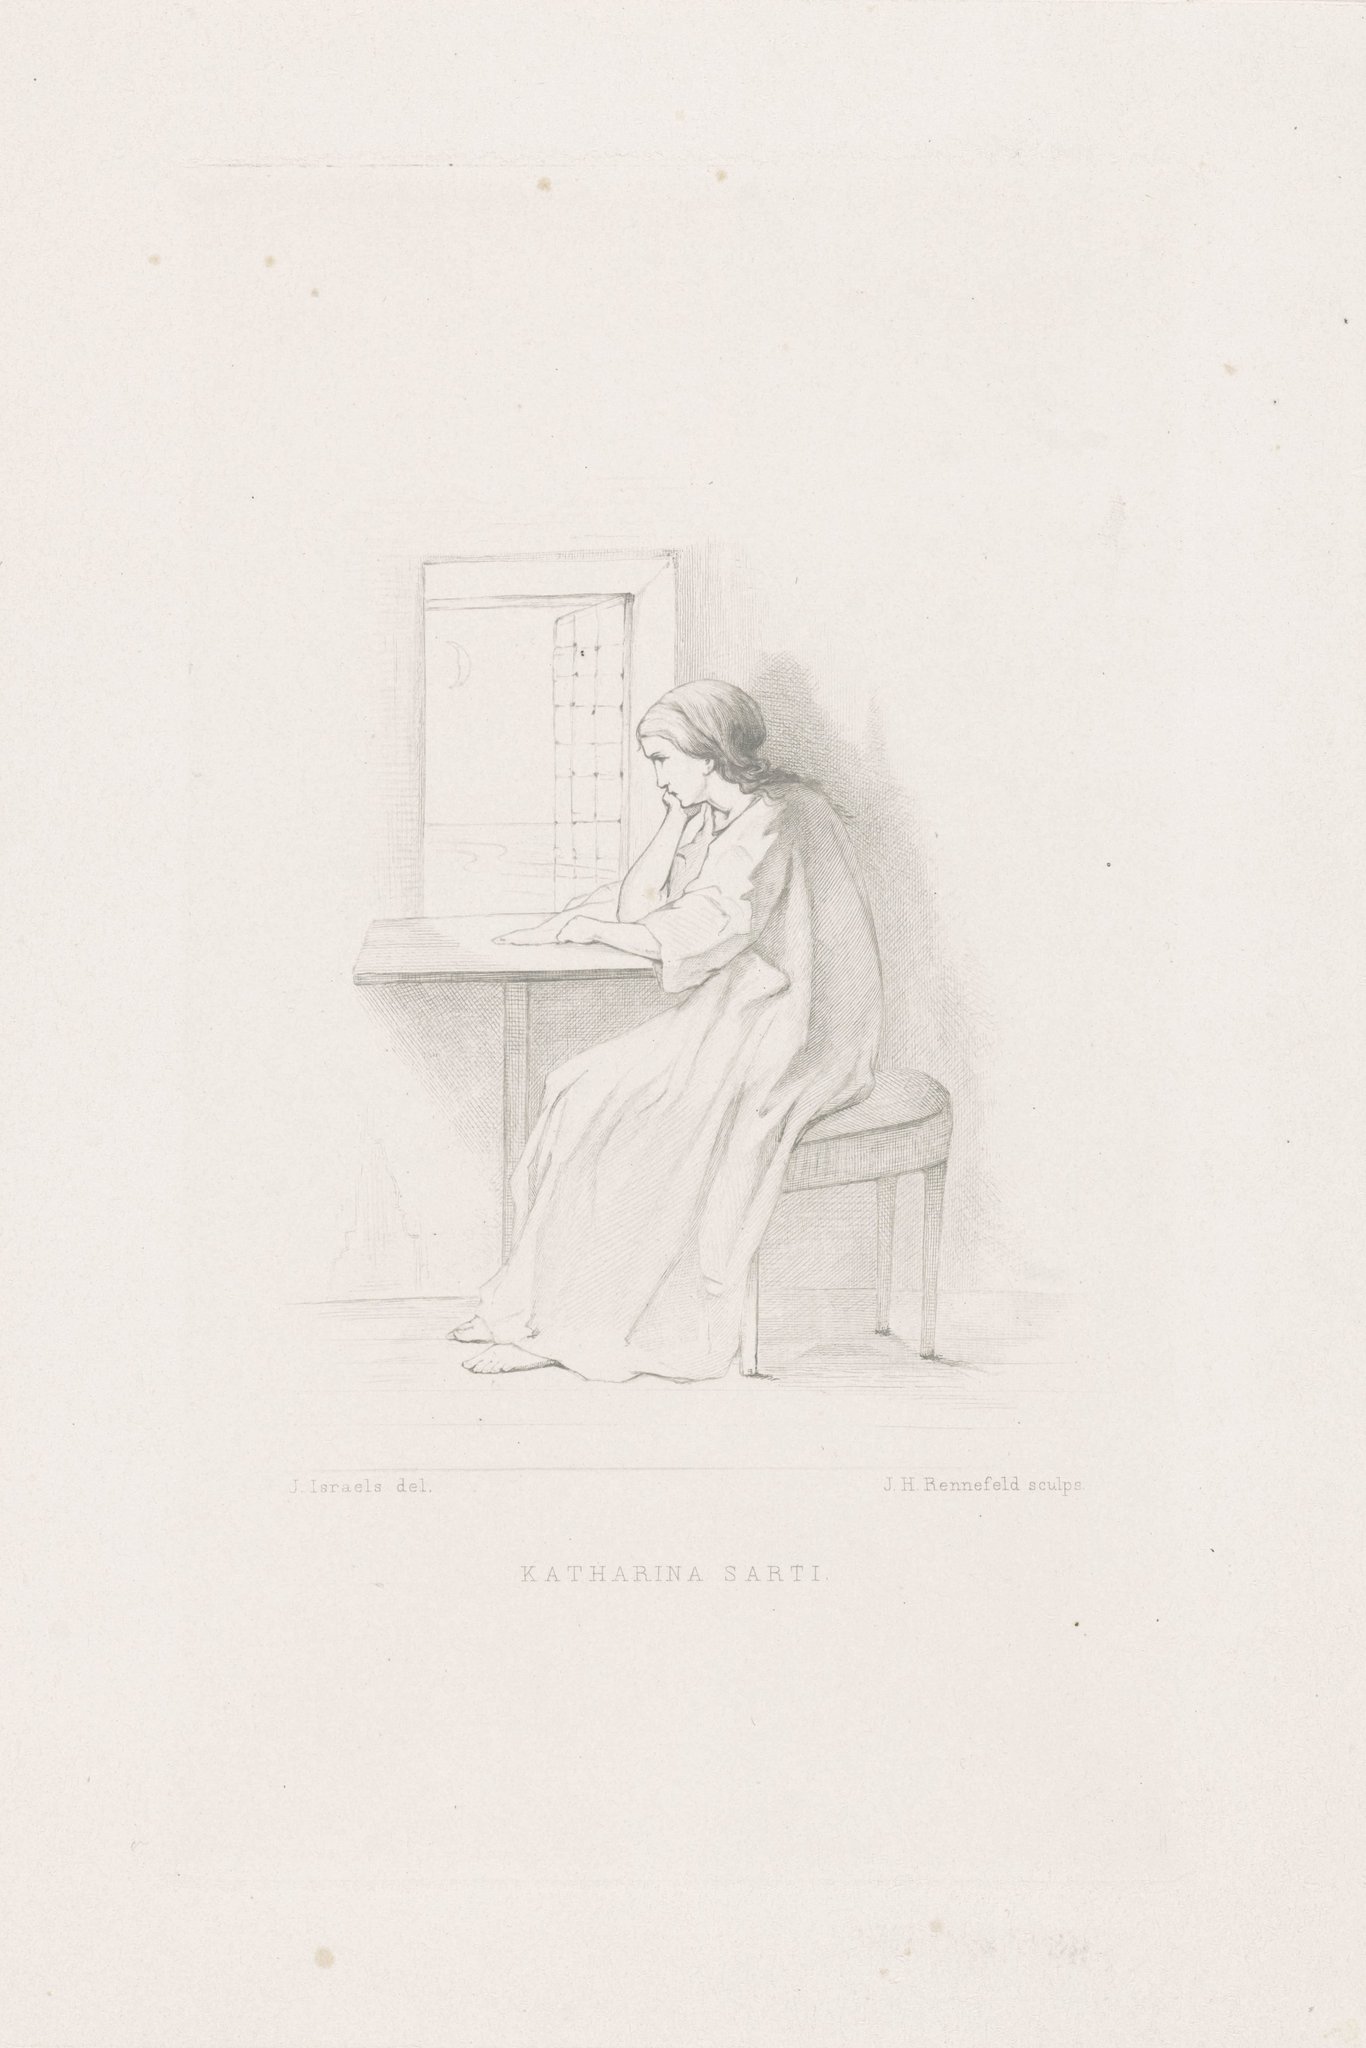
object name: print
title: Katharina Sarti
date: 1845-1877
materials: paper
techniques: roulette, engraving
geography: amsterdam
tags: waning moon, i.e. facing this way (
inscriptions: collector's mark: Lugt 2233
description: Katharina Sarti zit aan een tafel bij het venster en kijkt naar buiten. Door het venster is een weg met daarboven een halve maan te zien.